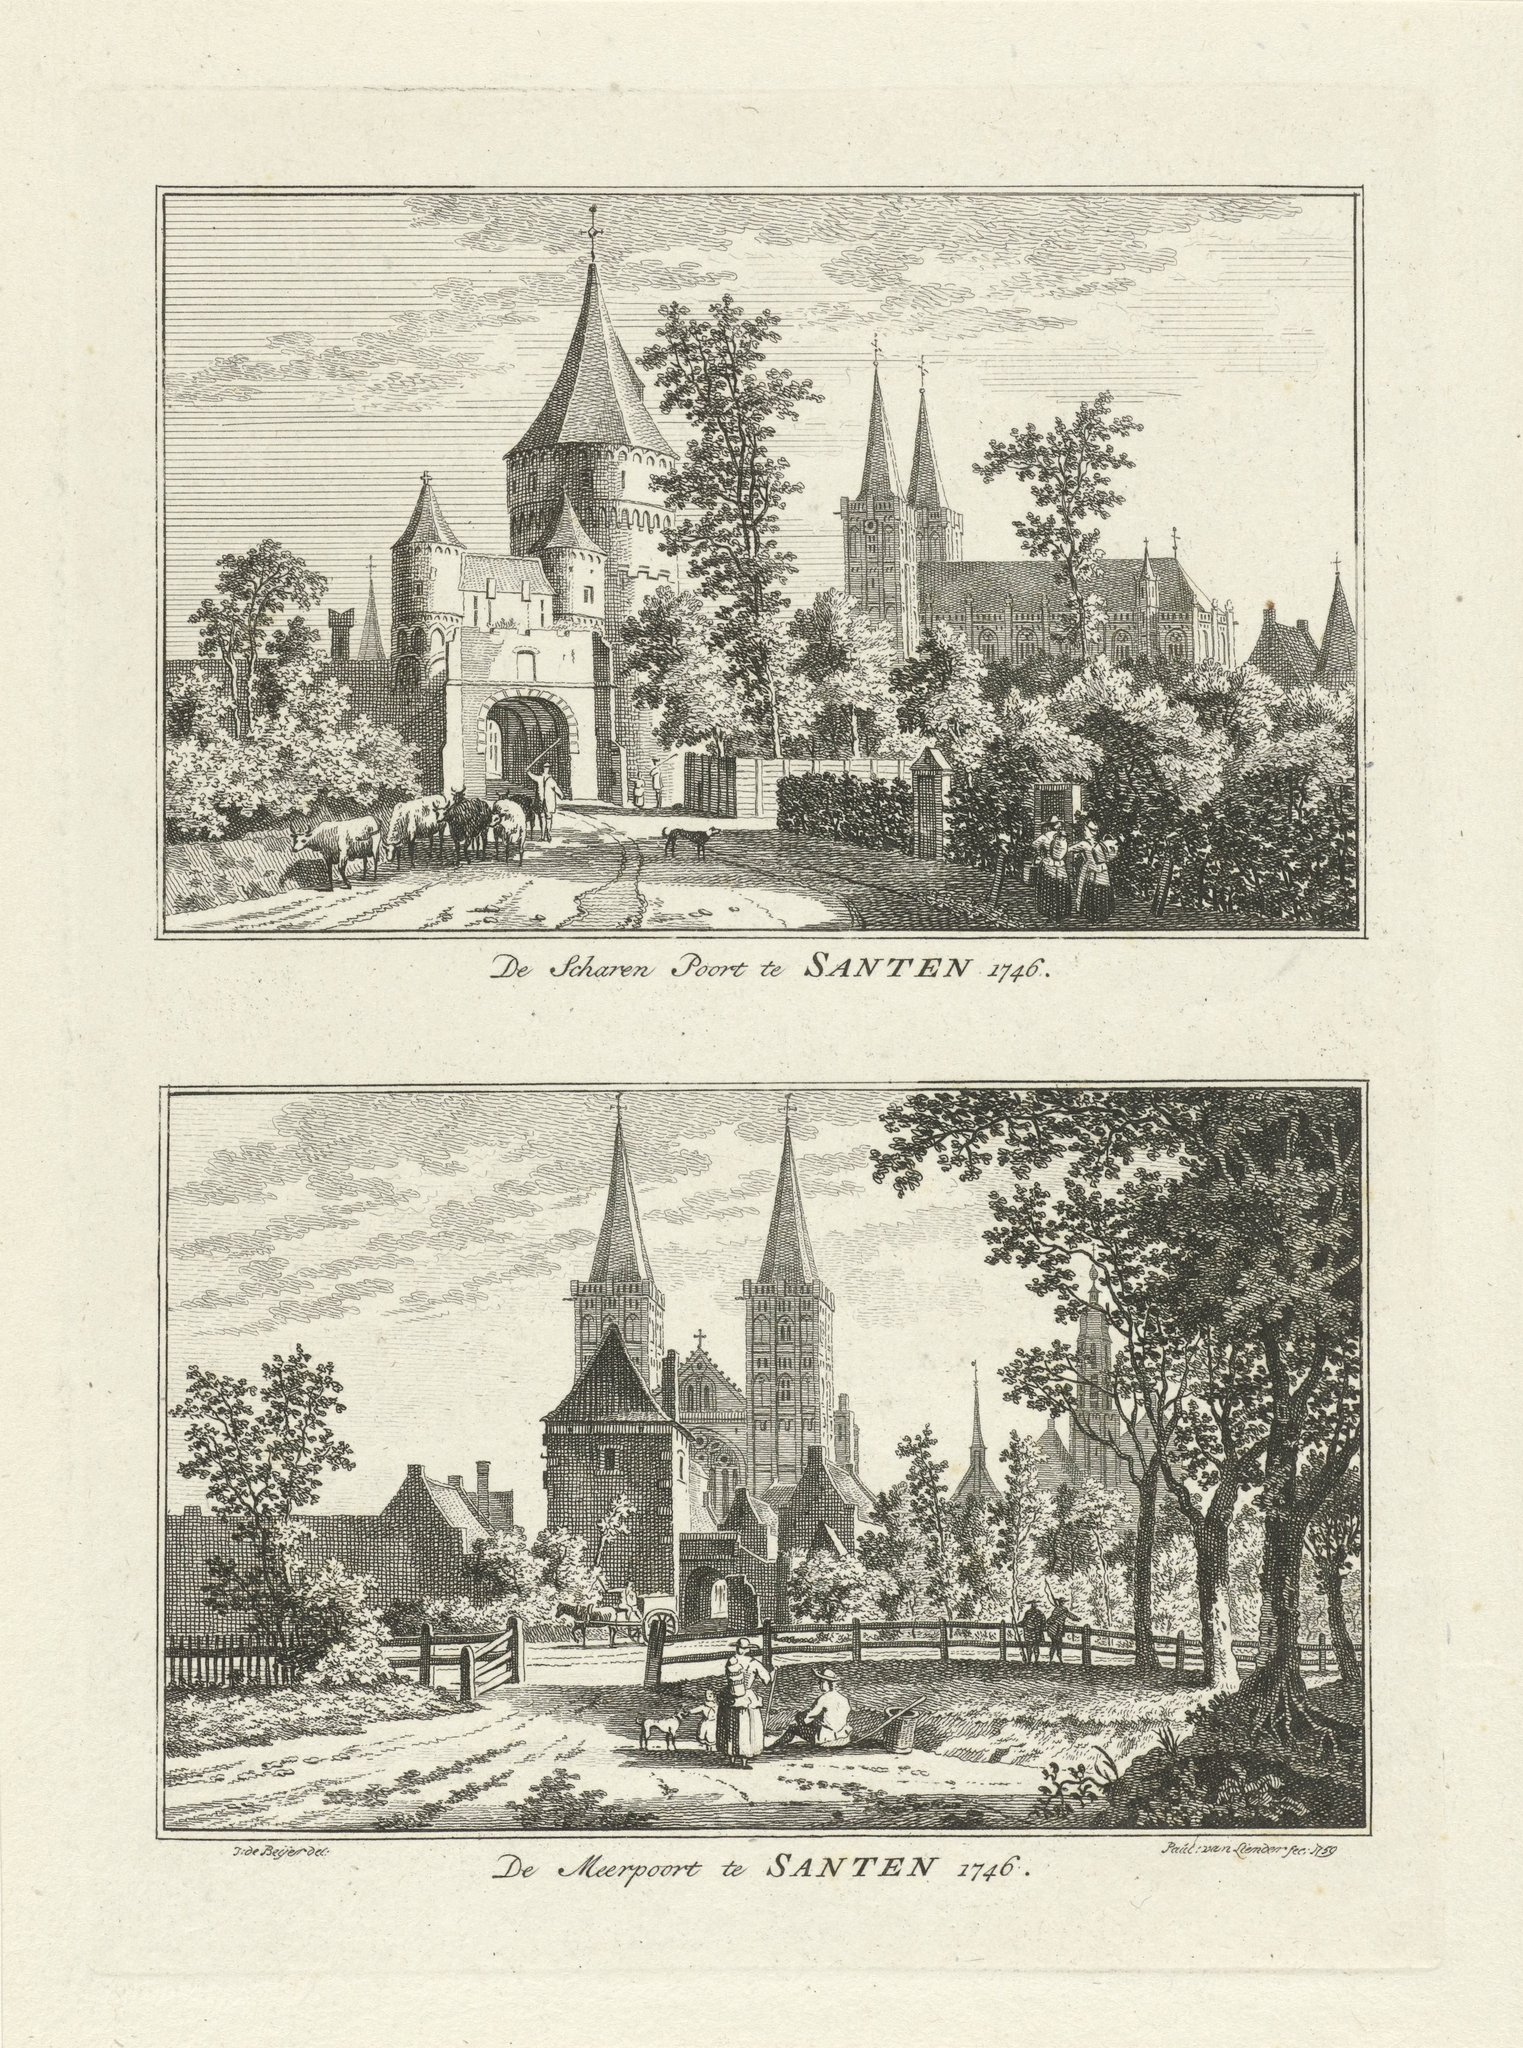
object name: print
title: Scharenpoort en Meerpoort te Xanten, 1746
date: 1759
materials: paper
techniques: etching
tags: city-gate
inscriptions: collector's mark: Lugt 240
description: Twee voorstellingen van één plaat. Gezichten op de Scharenpoort (boven) en de Meerpoort (onder) in de Duitse stad Xanten. De prent maakt deel uit van een 100-delige serie met gezichten op dorpen en steden te Kleef.